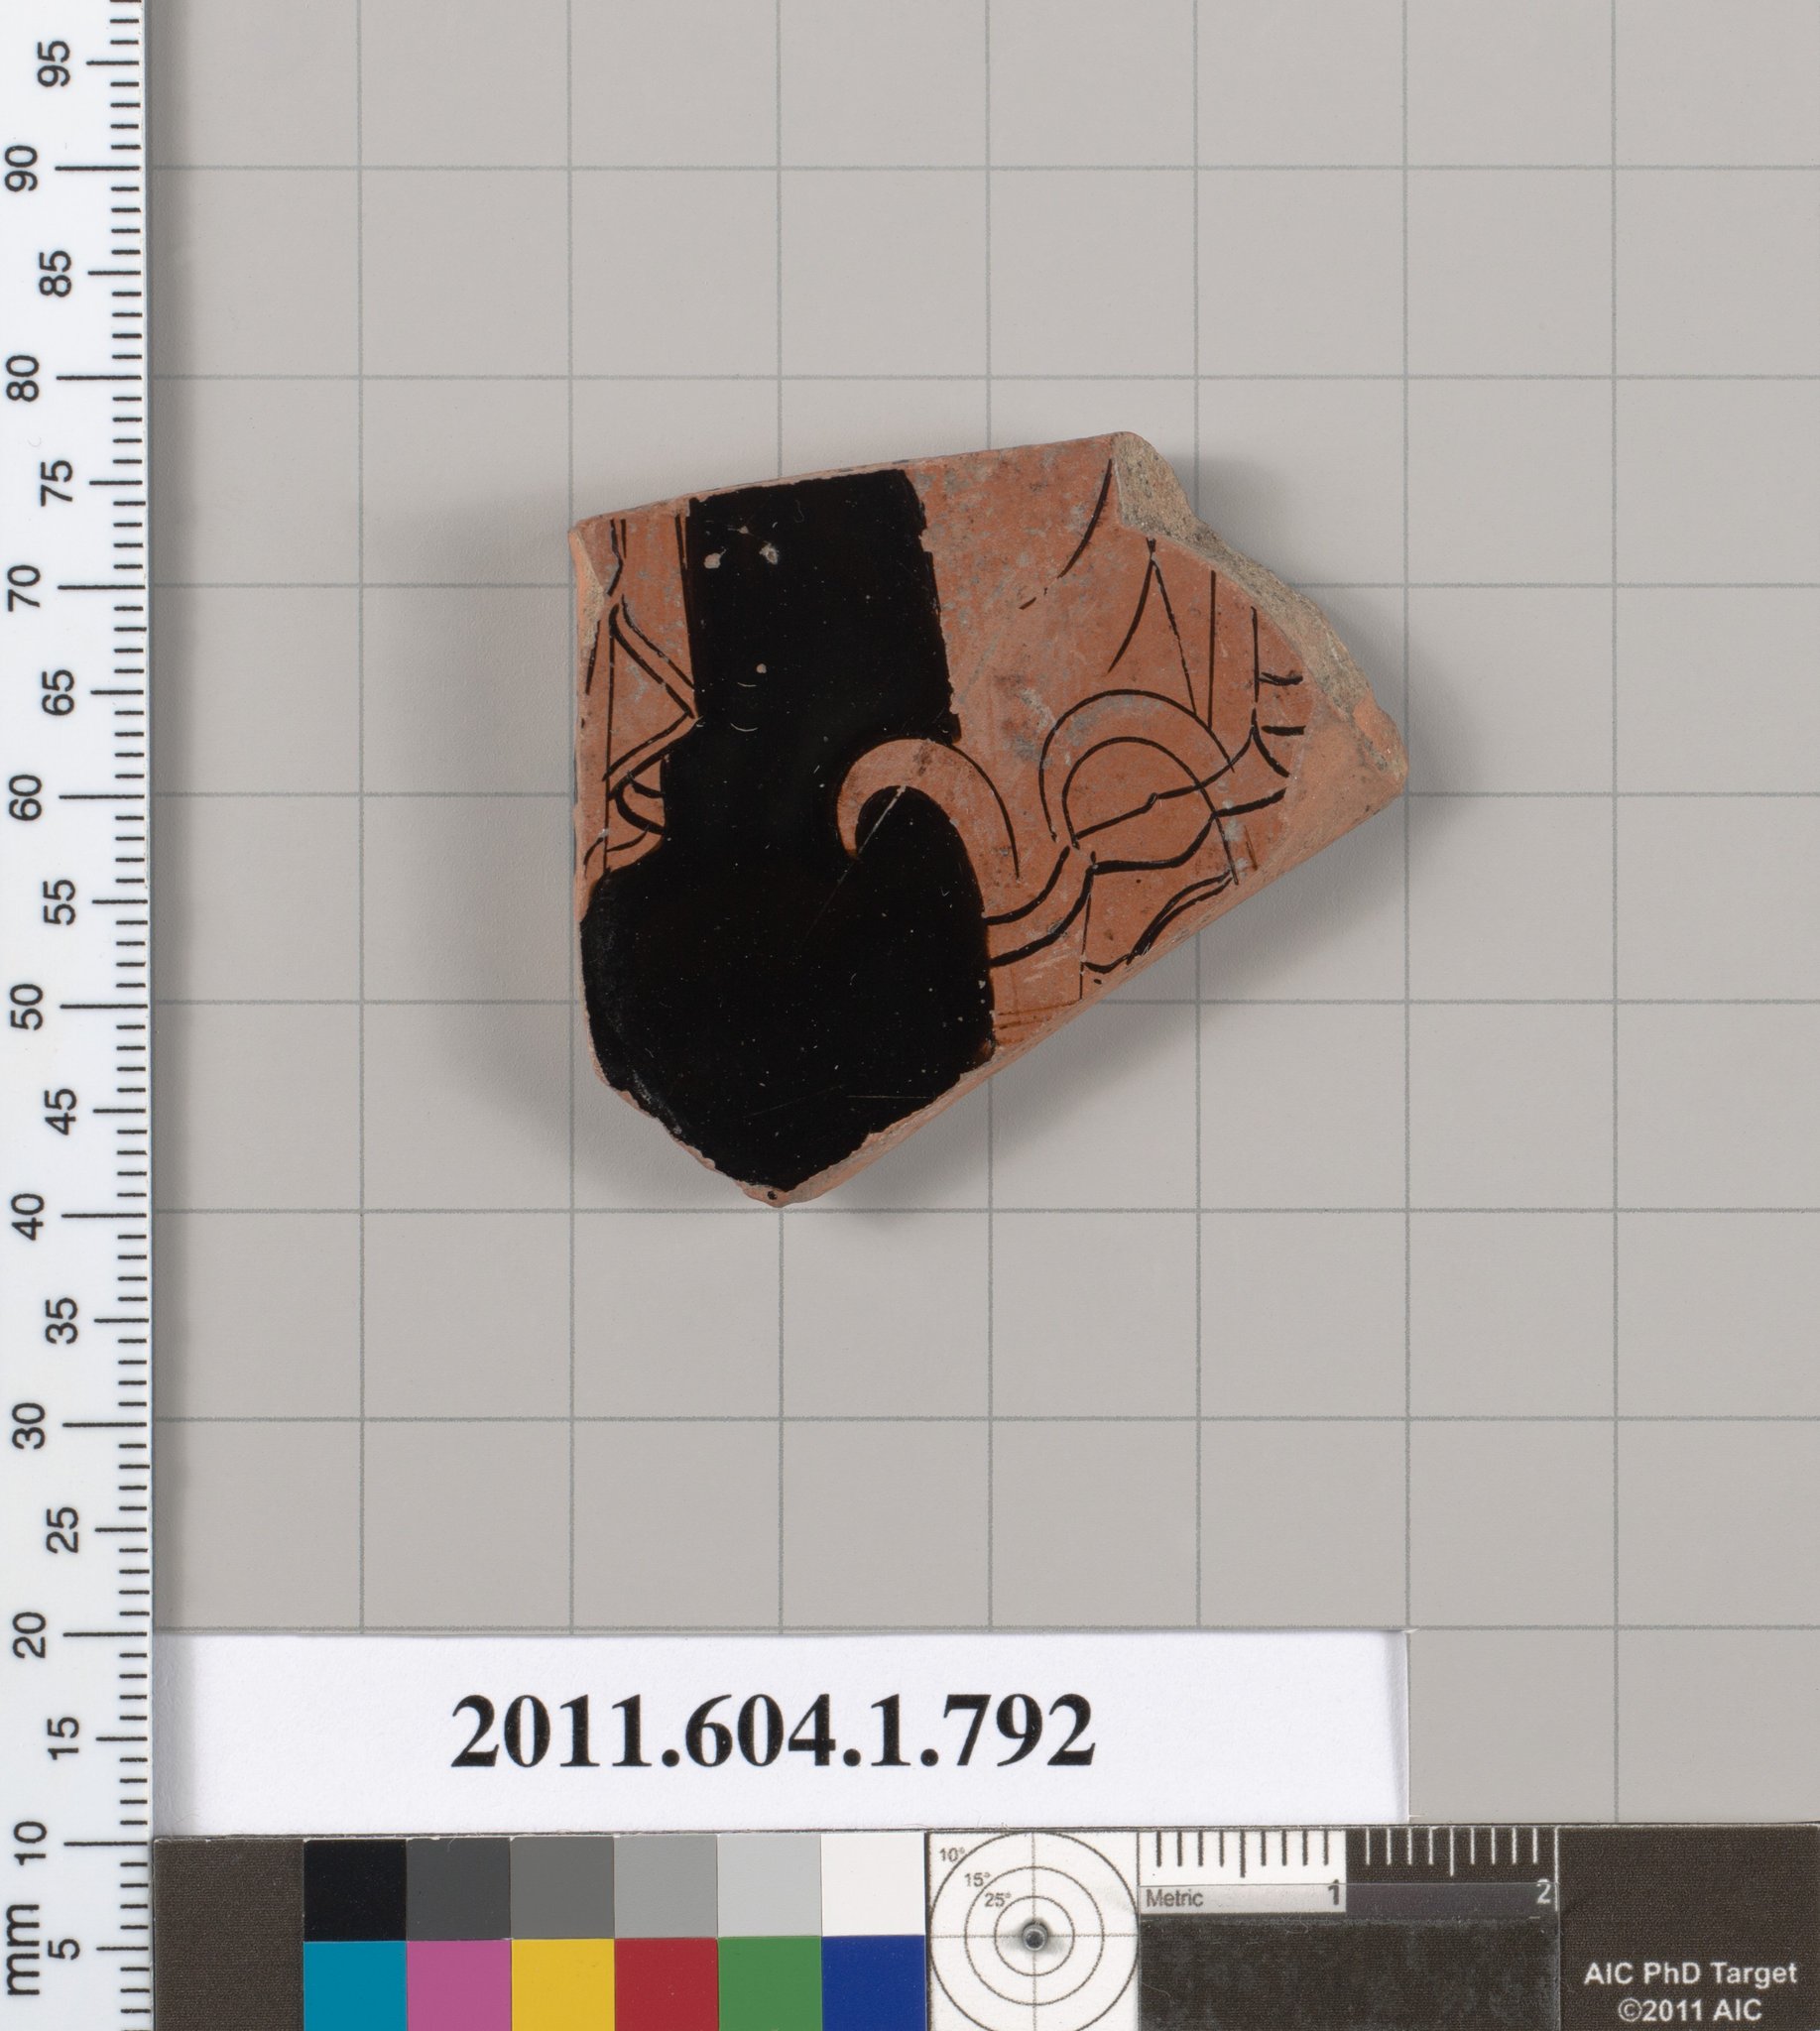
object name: kylix fragment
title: Terracotta fragment of a kylix (drinking cup)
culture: greek, attic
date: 490-480 BCE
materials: terracotta